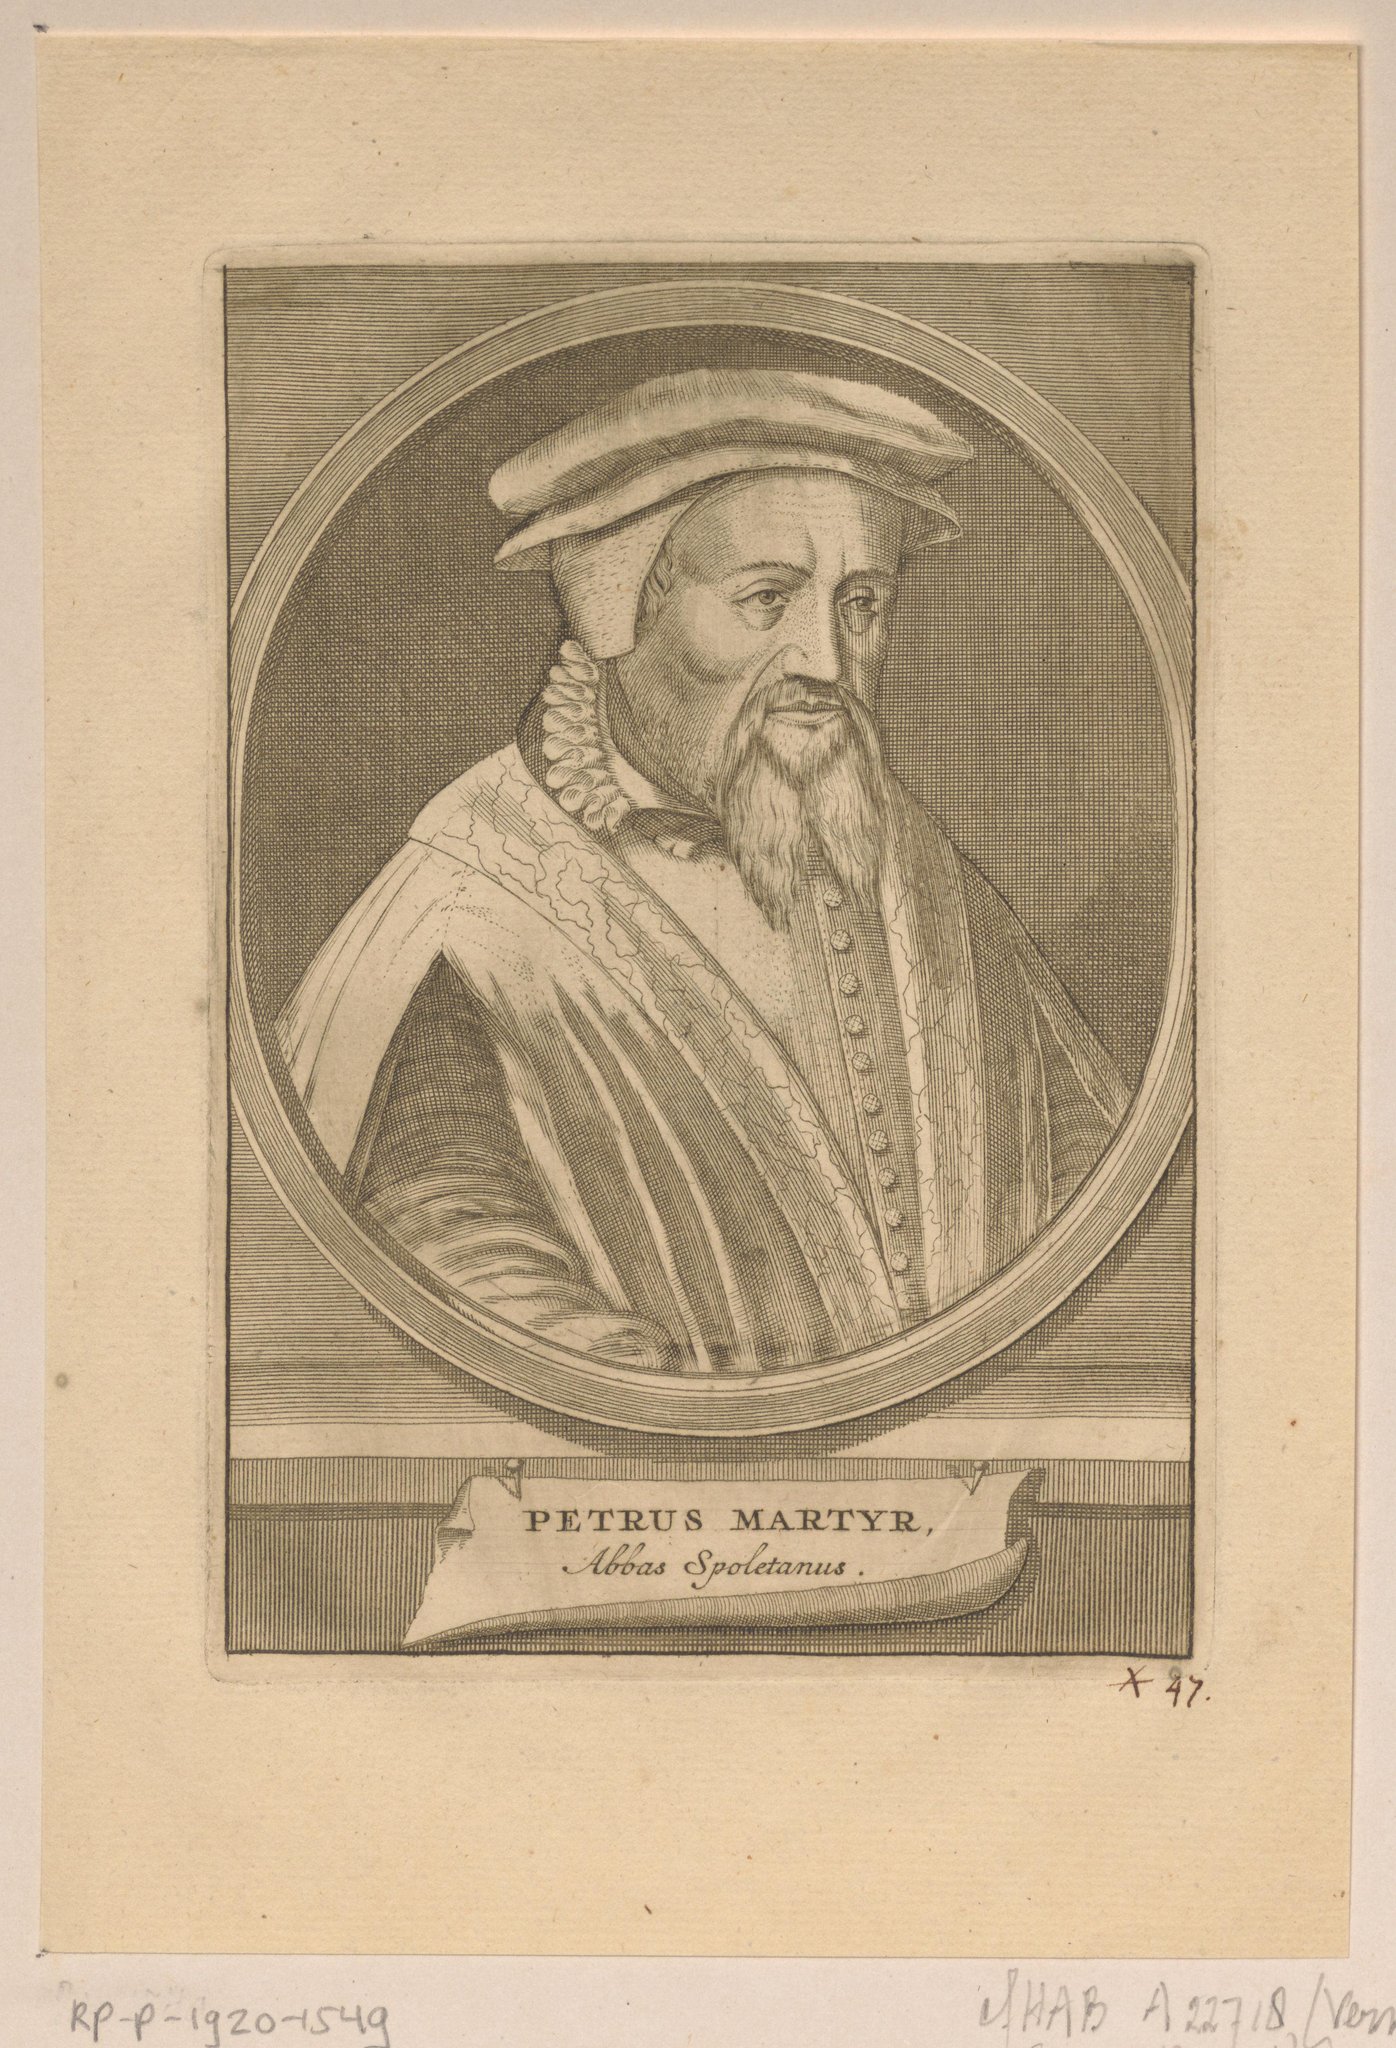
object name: print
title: Protestantse hervormers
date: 1690-1729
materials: paper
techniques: engraving, etching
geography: the hague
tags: theologian, ornament ~ medallion, historical persons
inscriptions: number: ‘*47’, collector's mark: Lugt 2228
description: Prent waarschijnlijk uit: Le miroir des portraits des premiers reformateurs des eglises protestantes. Leiden: Pieter van der Aa, [ca. 1690-1729]. Eerdere staat gebruikt in serie uit 1599 en publicaties uit 1602 en 1604.